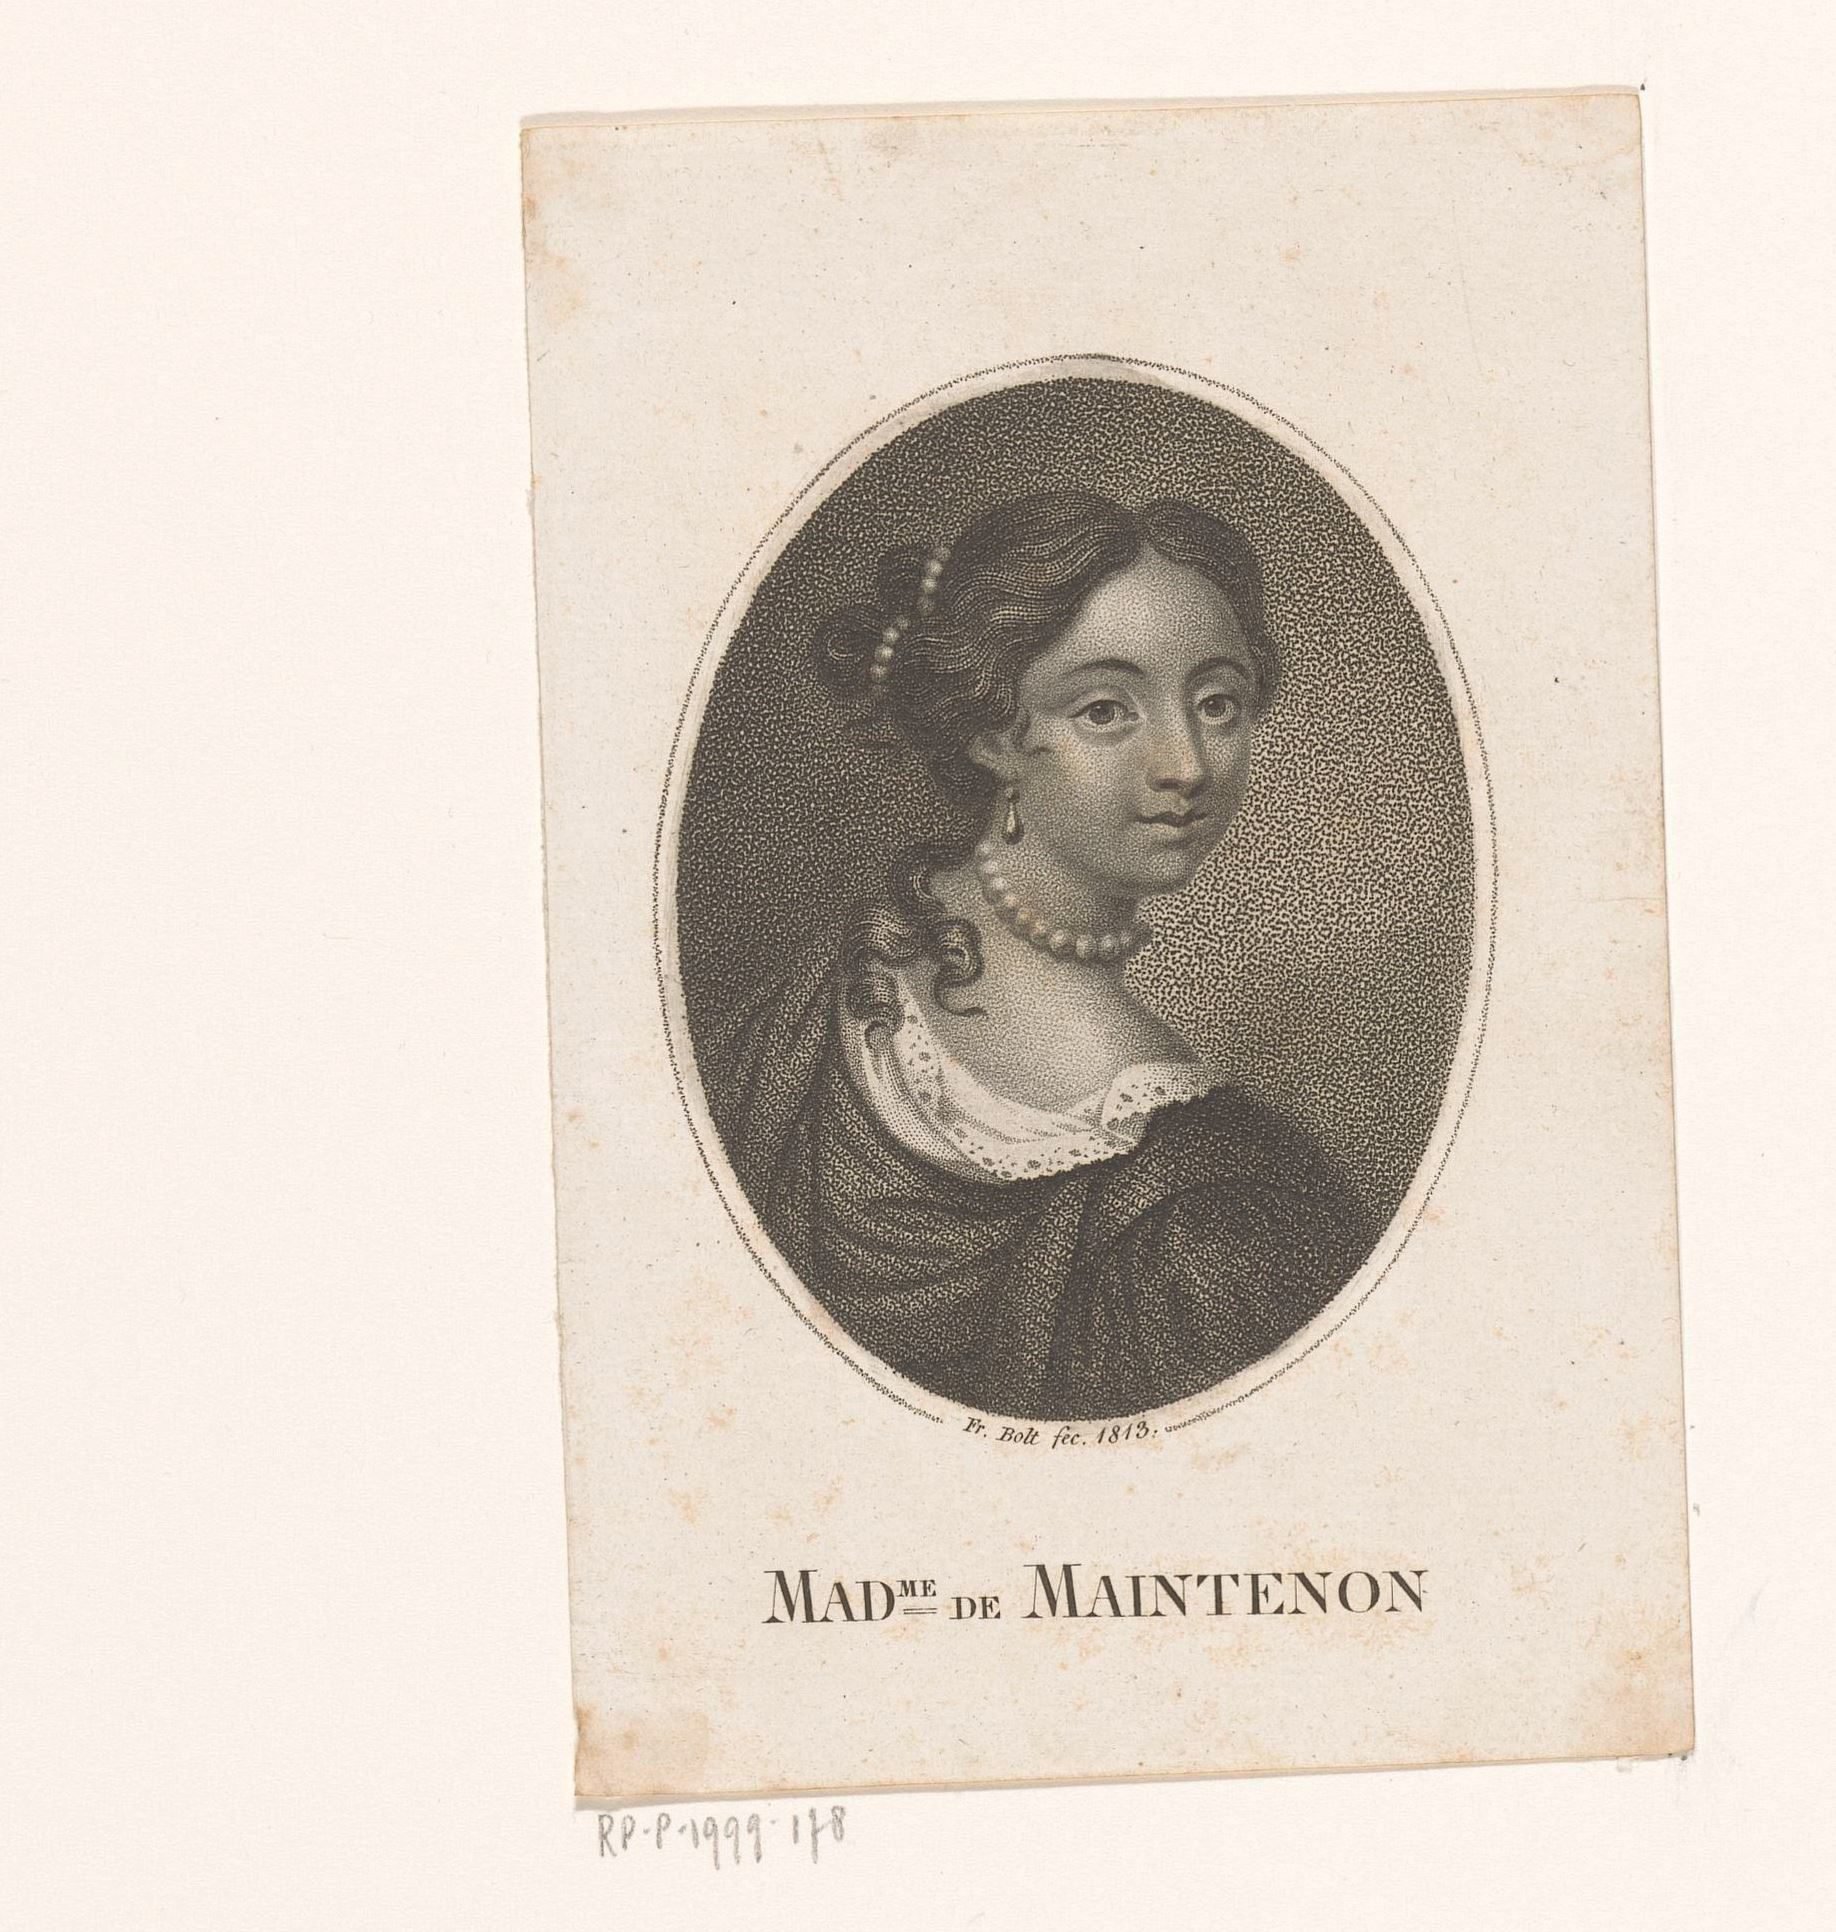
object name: print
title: Portret van Madame de Maintenon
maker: johann friedrich bolt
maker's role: print maker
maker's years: 1769-1836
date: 1813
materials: paper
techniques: stippling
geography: berlin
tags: madame de maintenon, historical persons - bb - woman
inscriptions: collector's mark: Lugt 2760, collector's mark: Lugt 2228